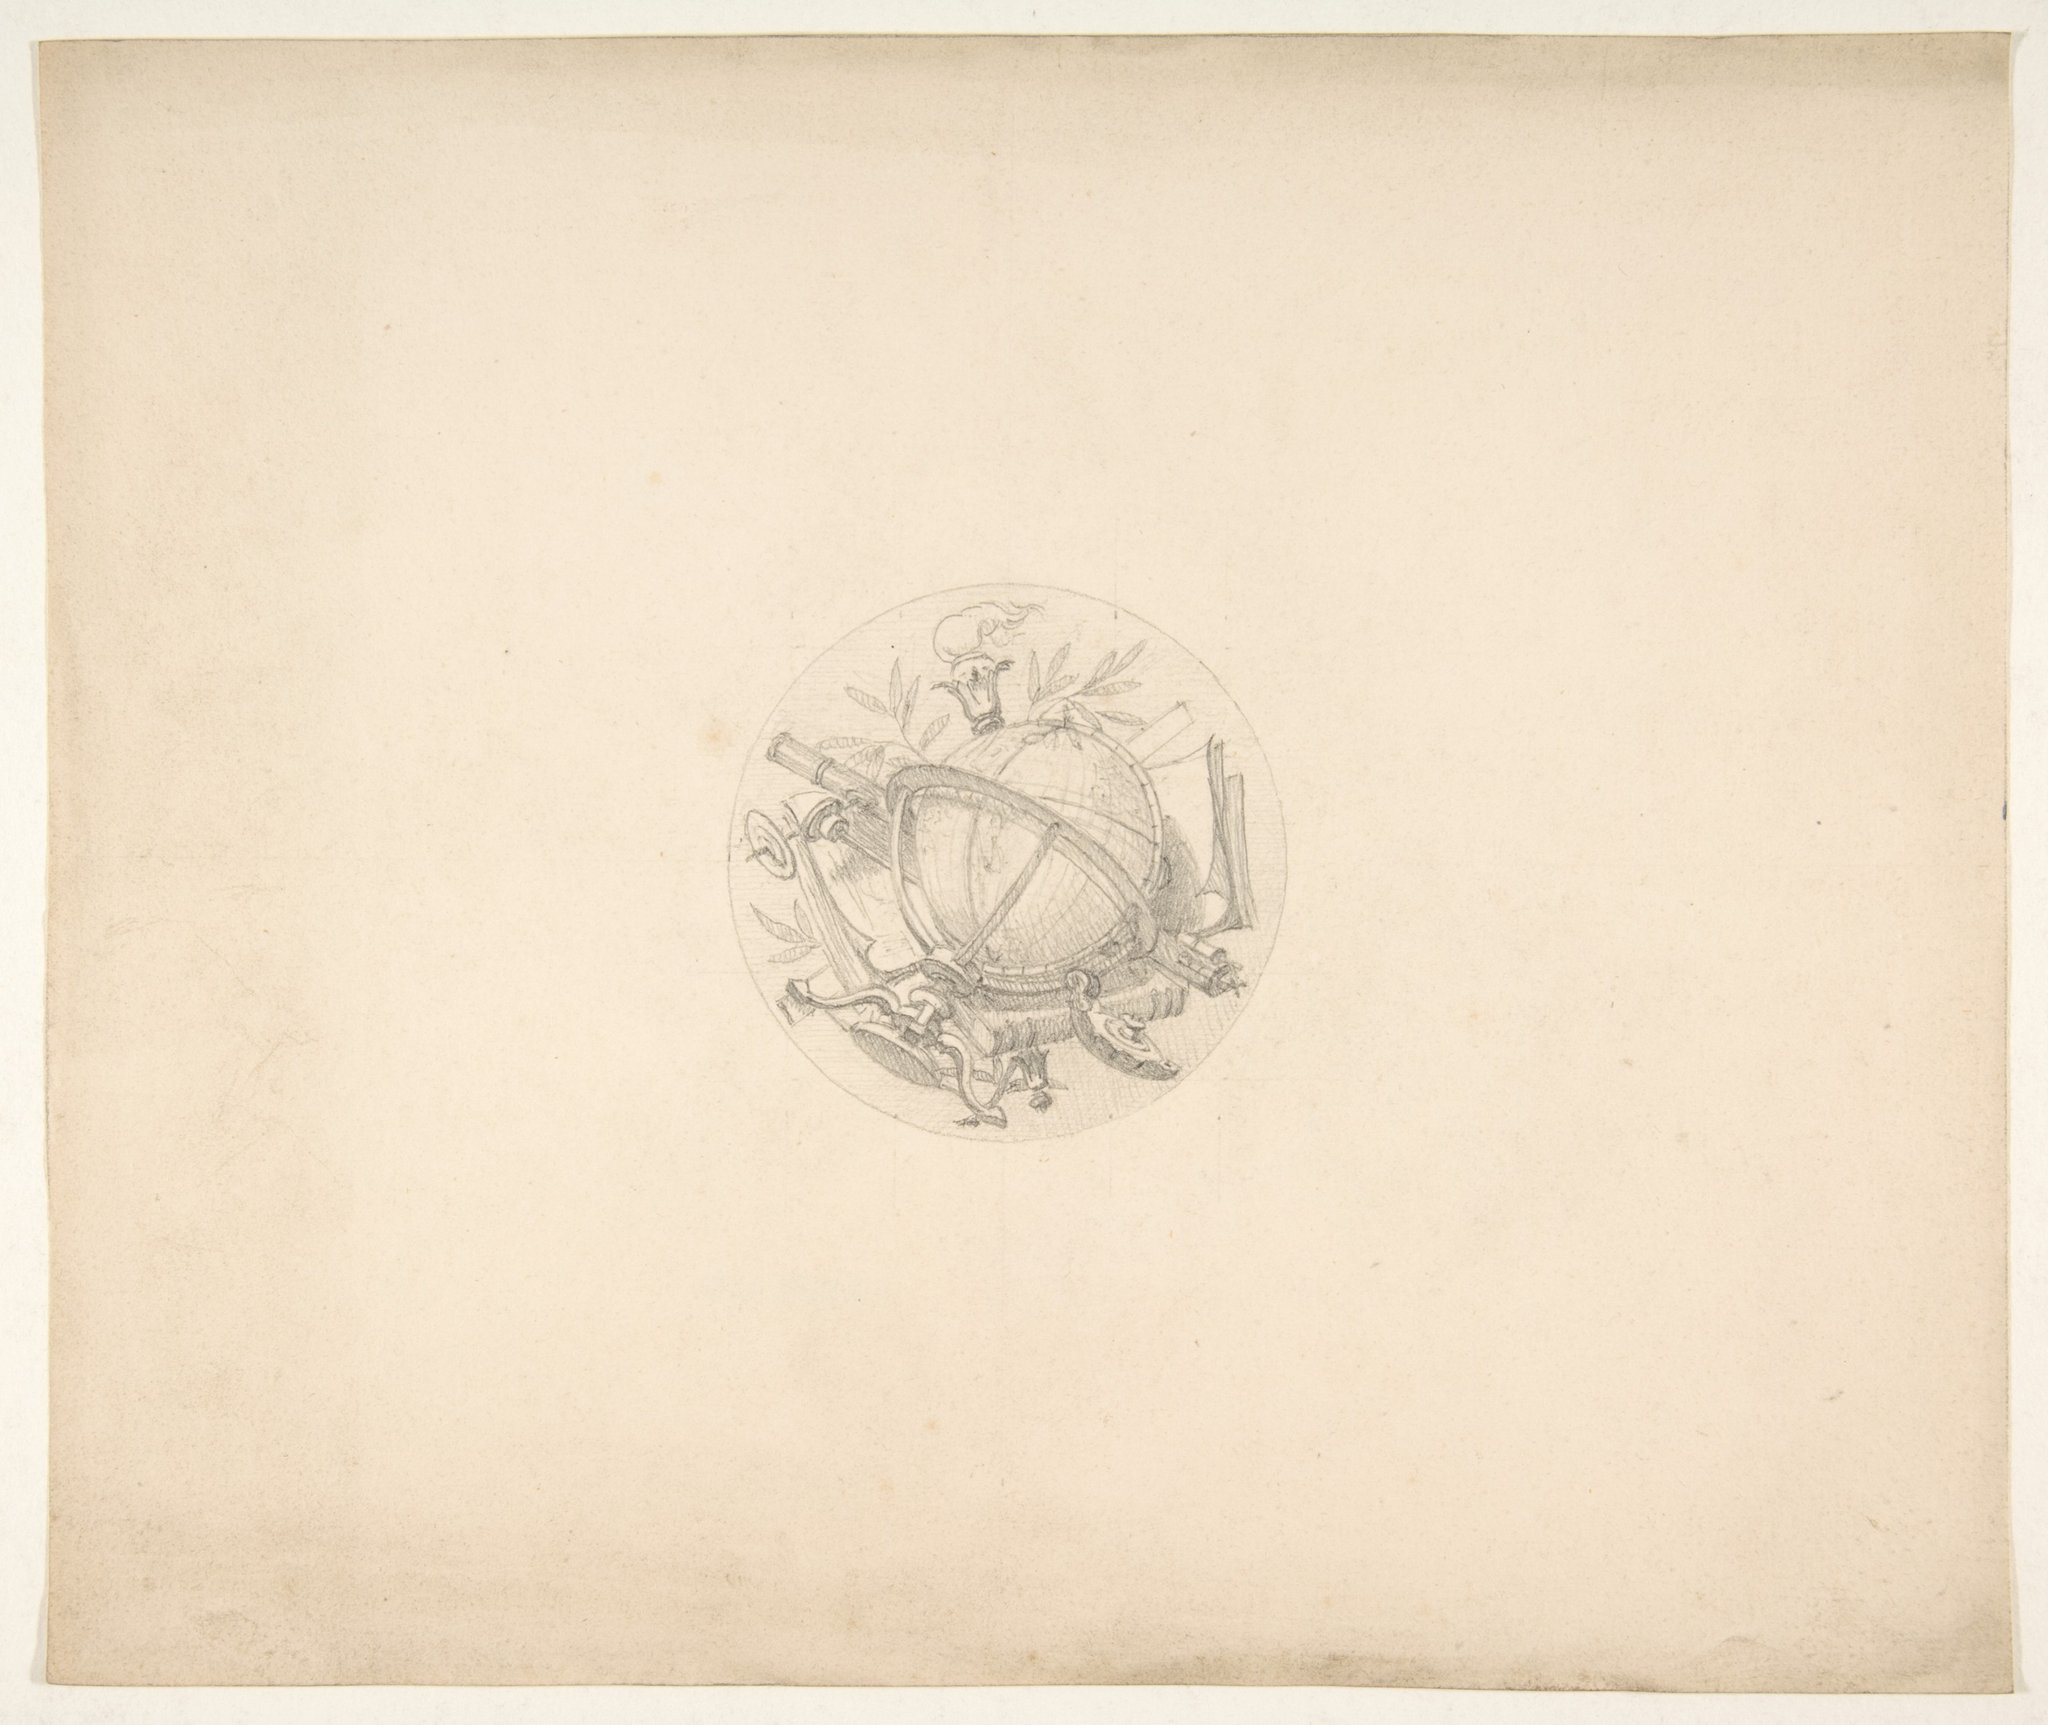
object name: drawing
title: Allegory of the Liberal Arts (Astronomy)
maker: jules-edmond-charles lachaise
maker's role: artist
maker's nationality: french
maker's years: 1897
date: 1851-1900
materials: graphite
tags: astronomy,globes